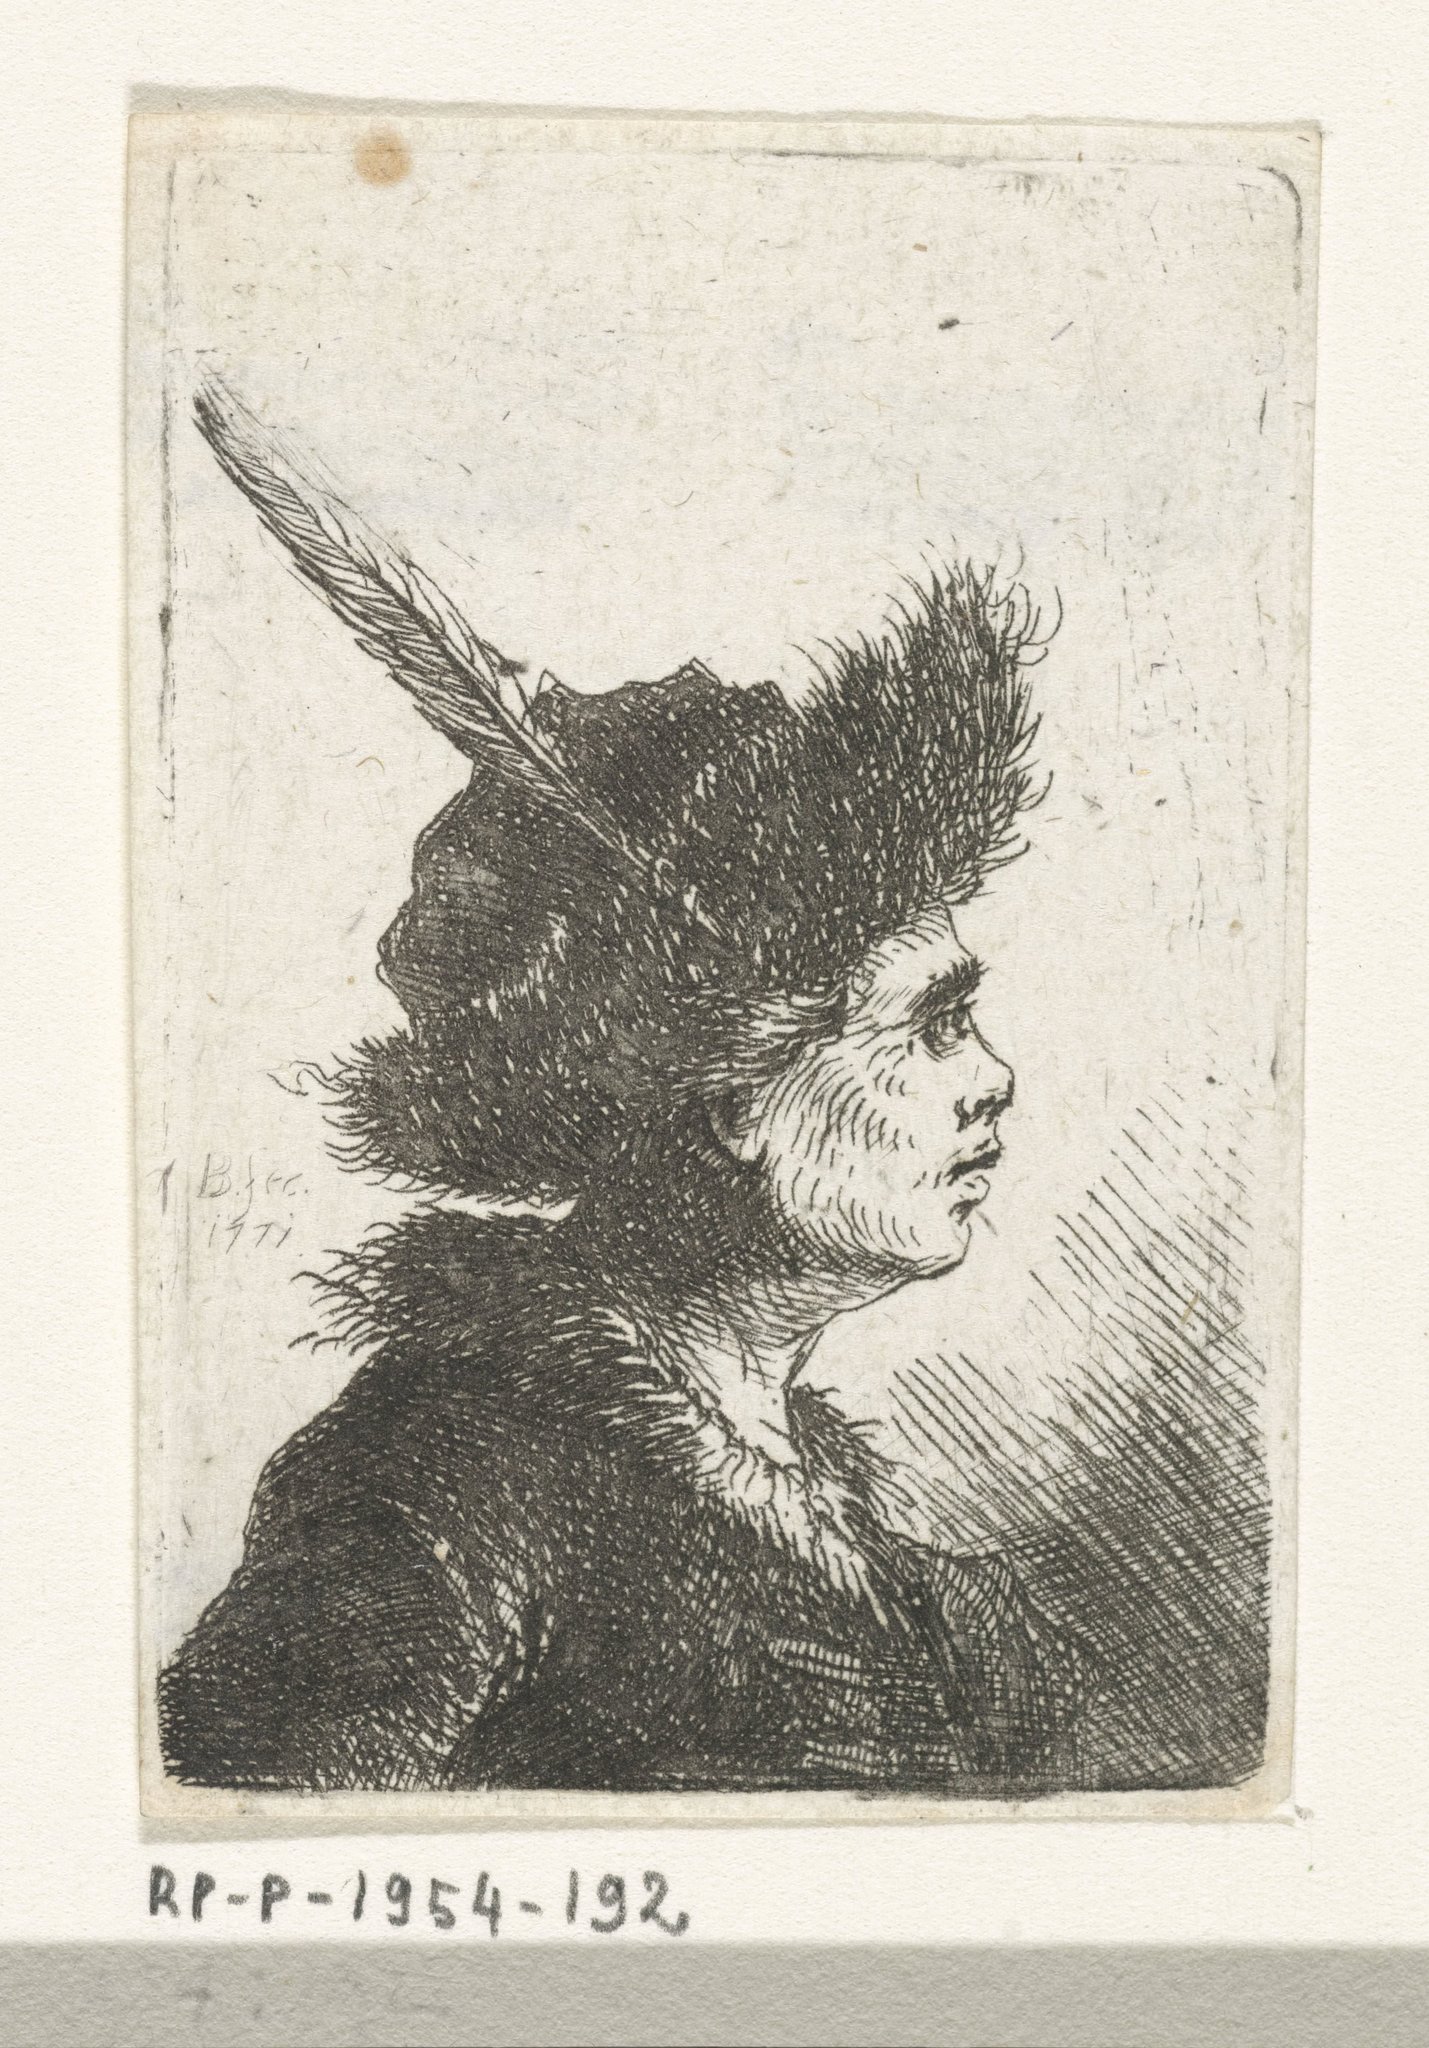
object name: print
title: Jonge man met Poolse muts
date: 1616-1719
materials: paper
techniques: etching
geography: netherlands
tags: head-gear: cap (+ men's clothes)